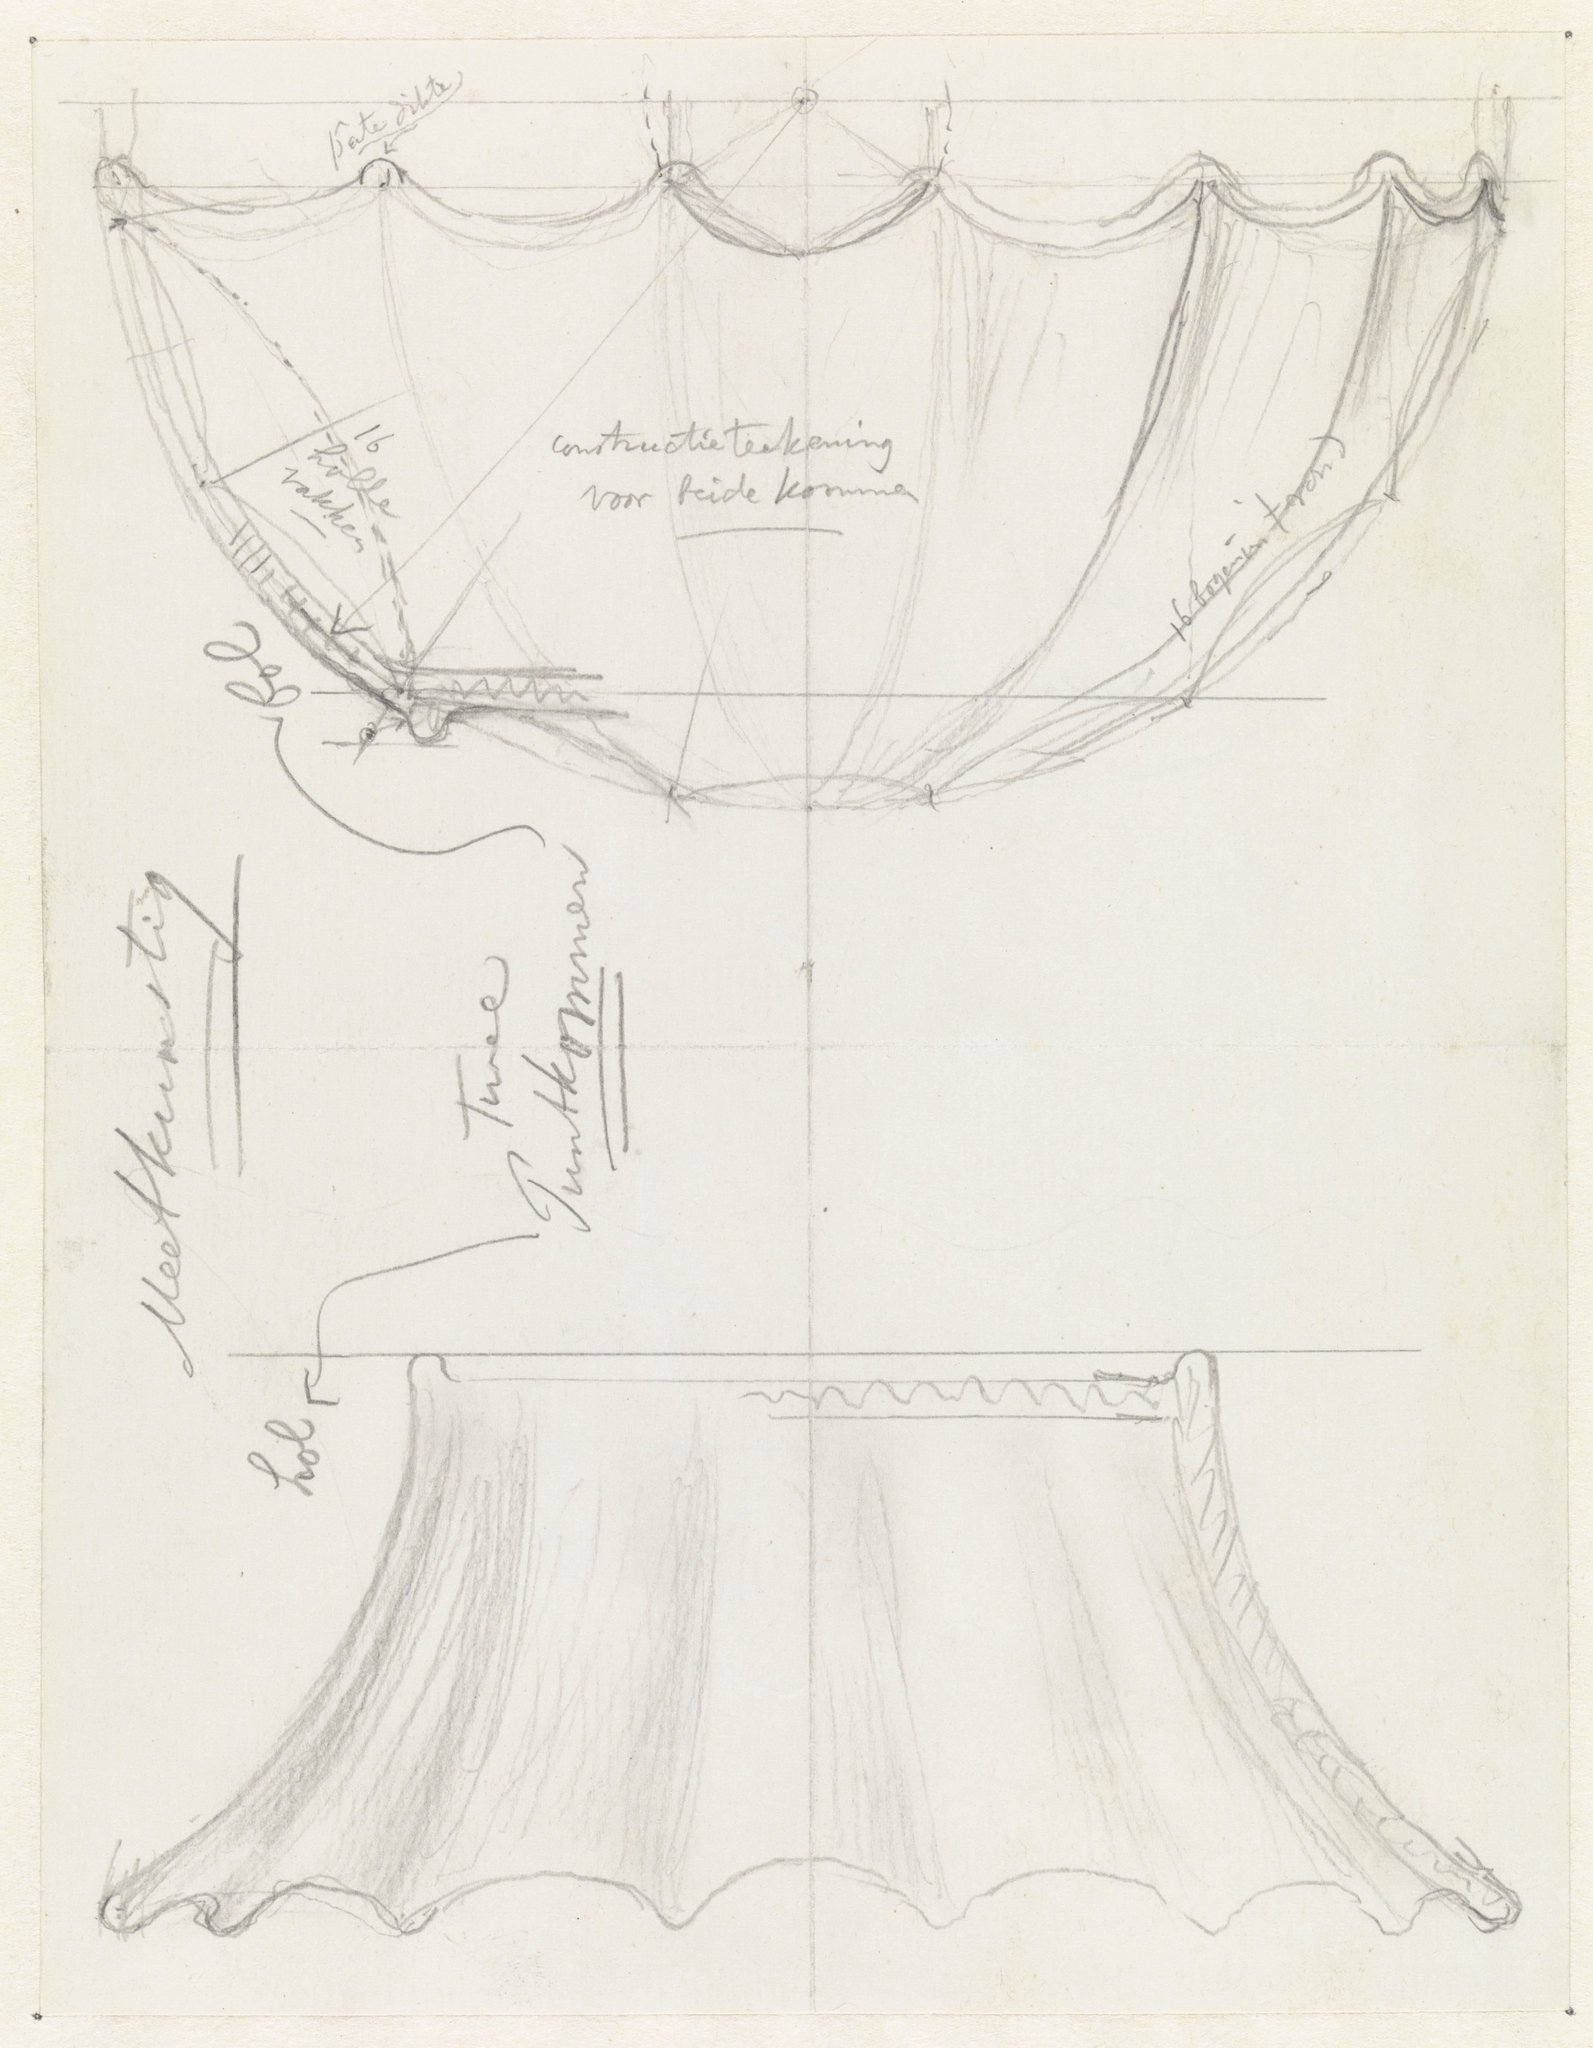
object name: drawing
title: Twee puntkommen, één bol en één hol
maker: theo colenbrander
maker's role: draughtsman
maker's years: 1841-1930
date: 1851-1930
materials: paper, pencil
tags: bowl, container of ceramics: jar, jug, pot, vase